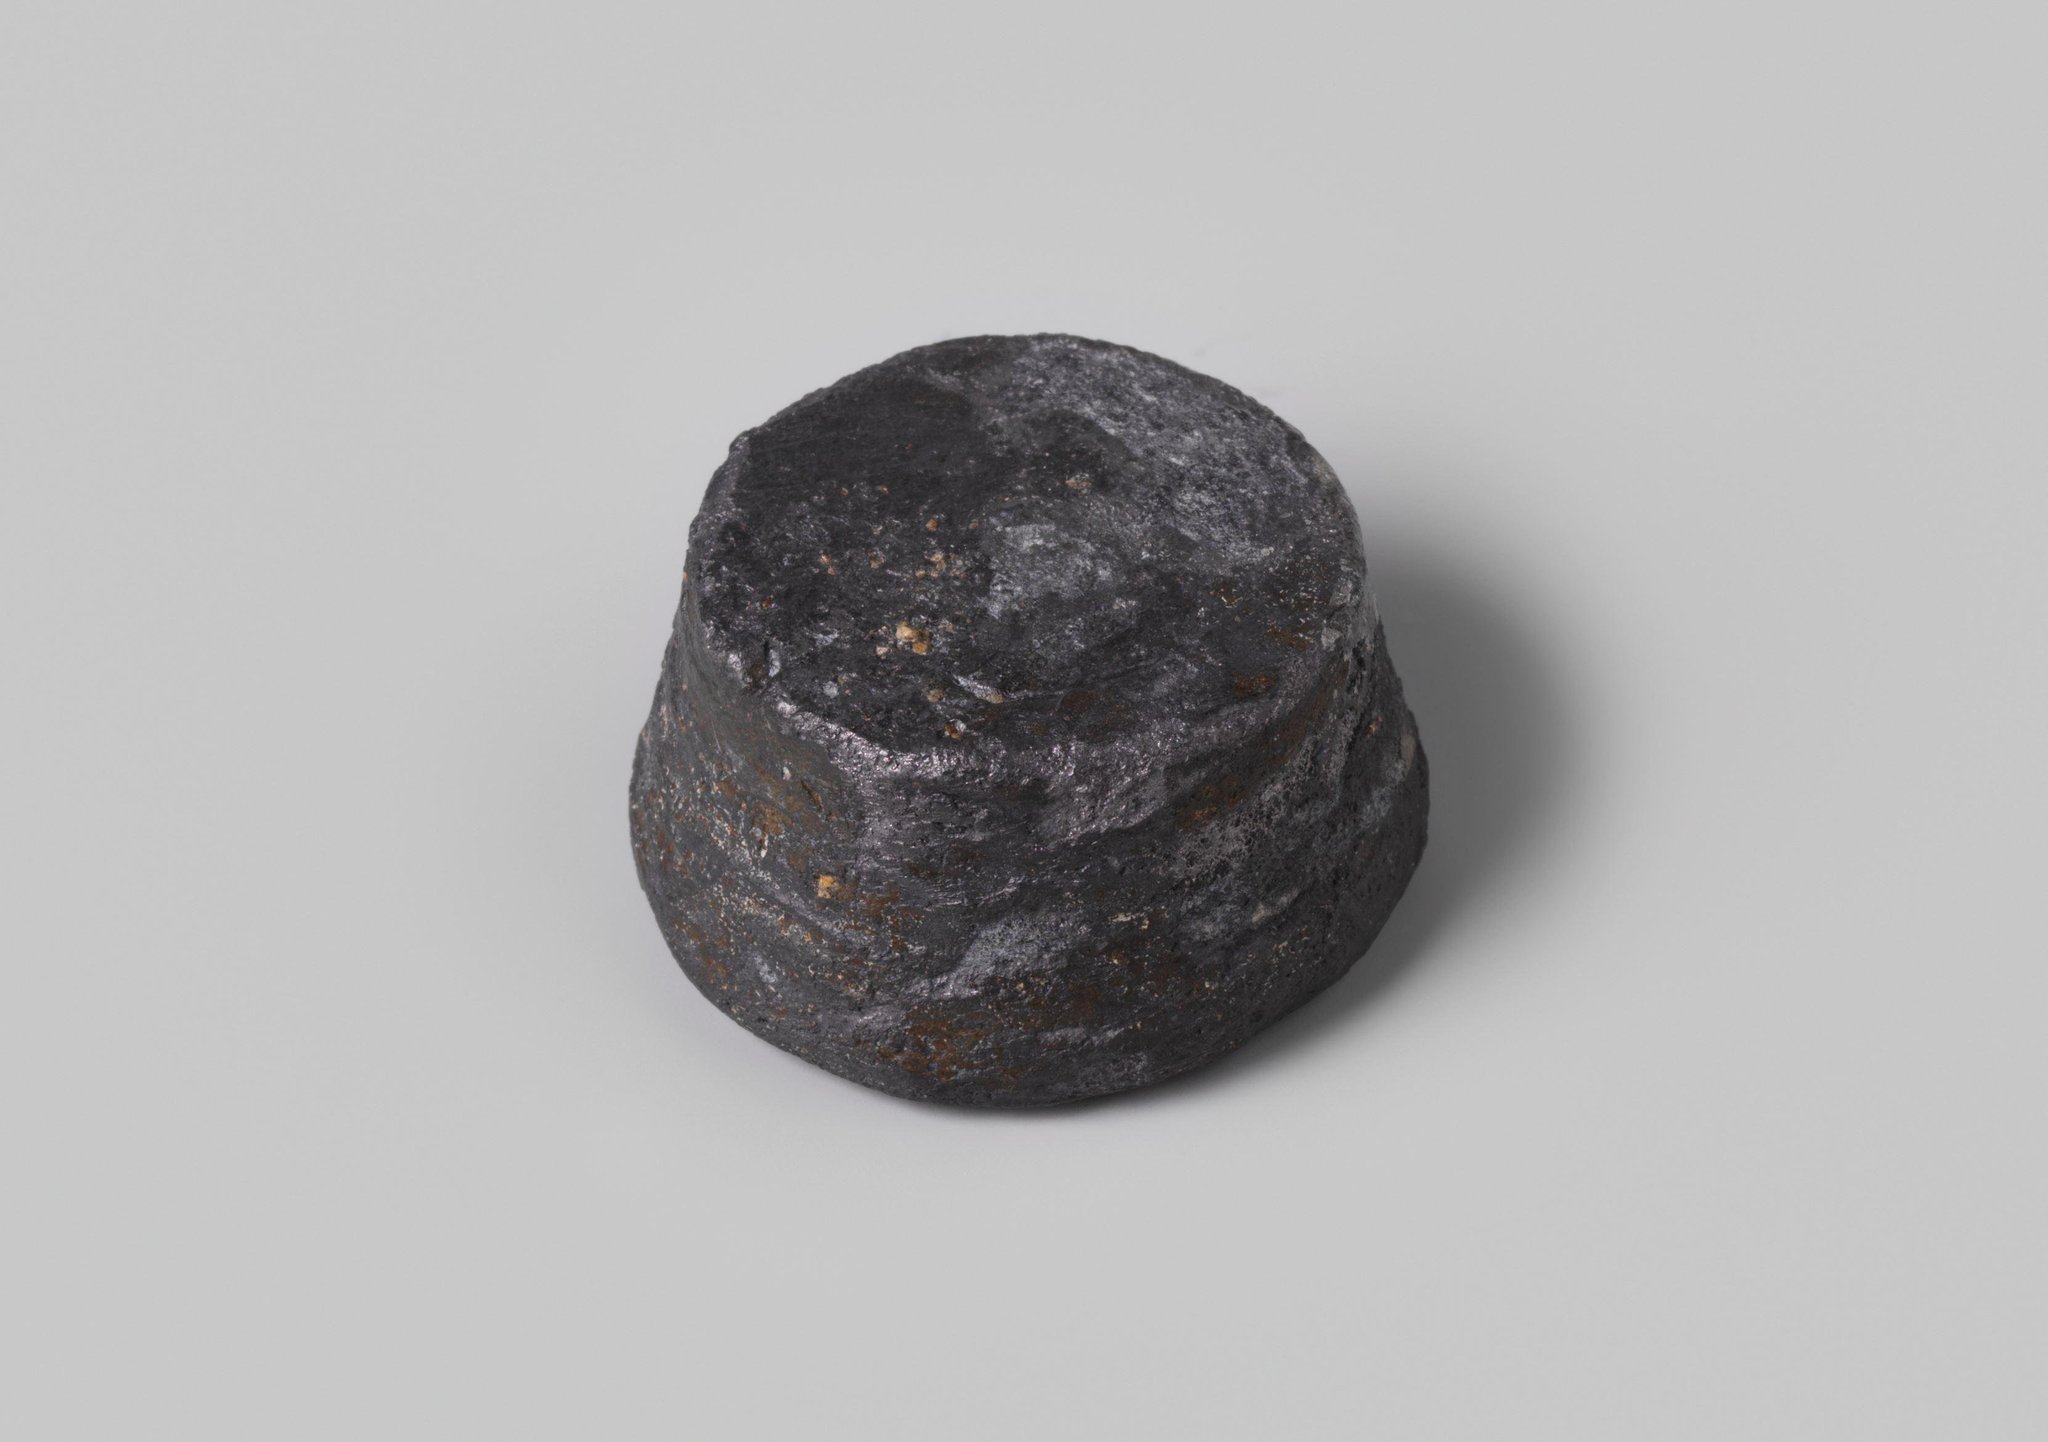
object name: blokgewicht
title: Block-shaped weight, lead, from the wreck of the Dutch East India ship Hollandia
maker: Anonymous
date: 1700-1743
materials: lead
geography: netherlands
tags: verenigde oostindische compagnie, hollandia (schip), annet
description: Block-shaped weight, circular, flat top and underside, tapering in section, corroded.